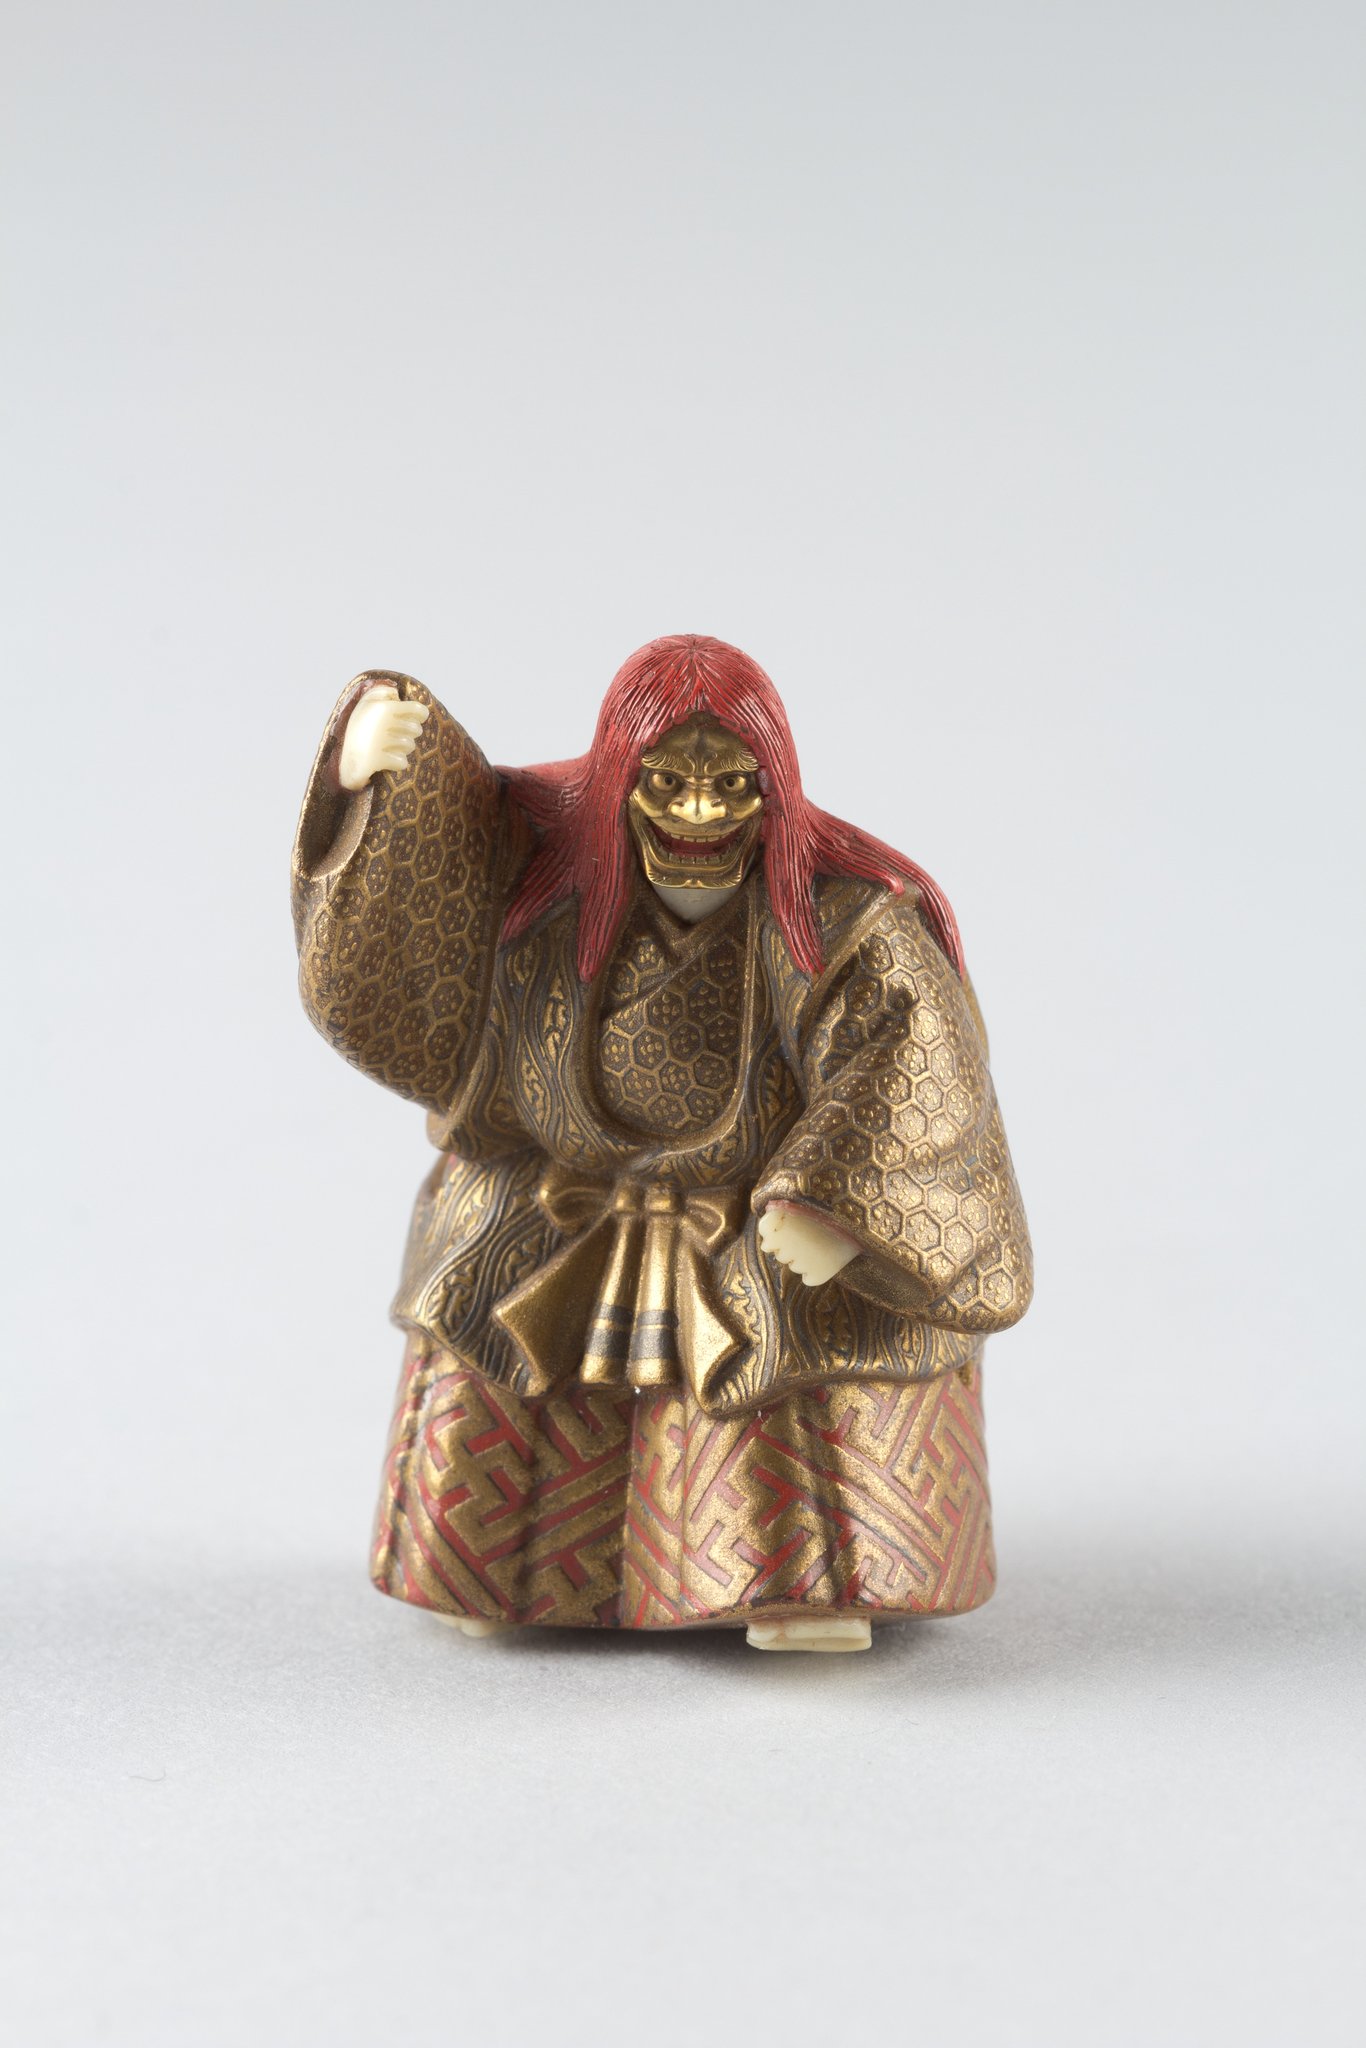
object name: netsuke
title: Netsuke of Shakkyō Dancer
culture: japanese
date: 1801-1833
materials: gold, ivory, wood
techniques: hiramakie, lacquer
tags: human figures